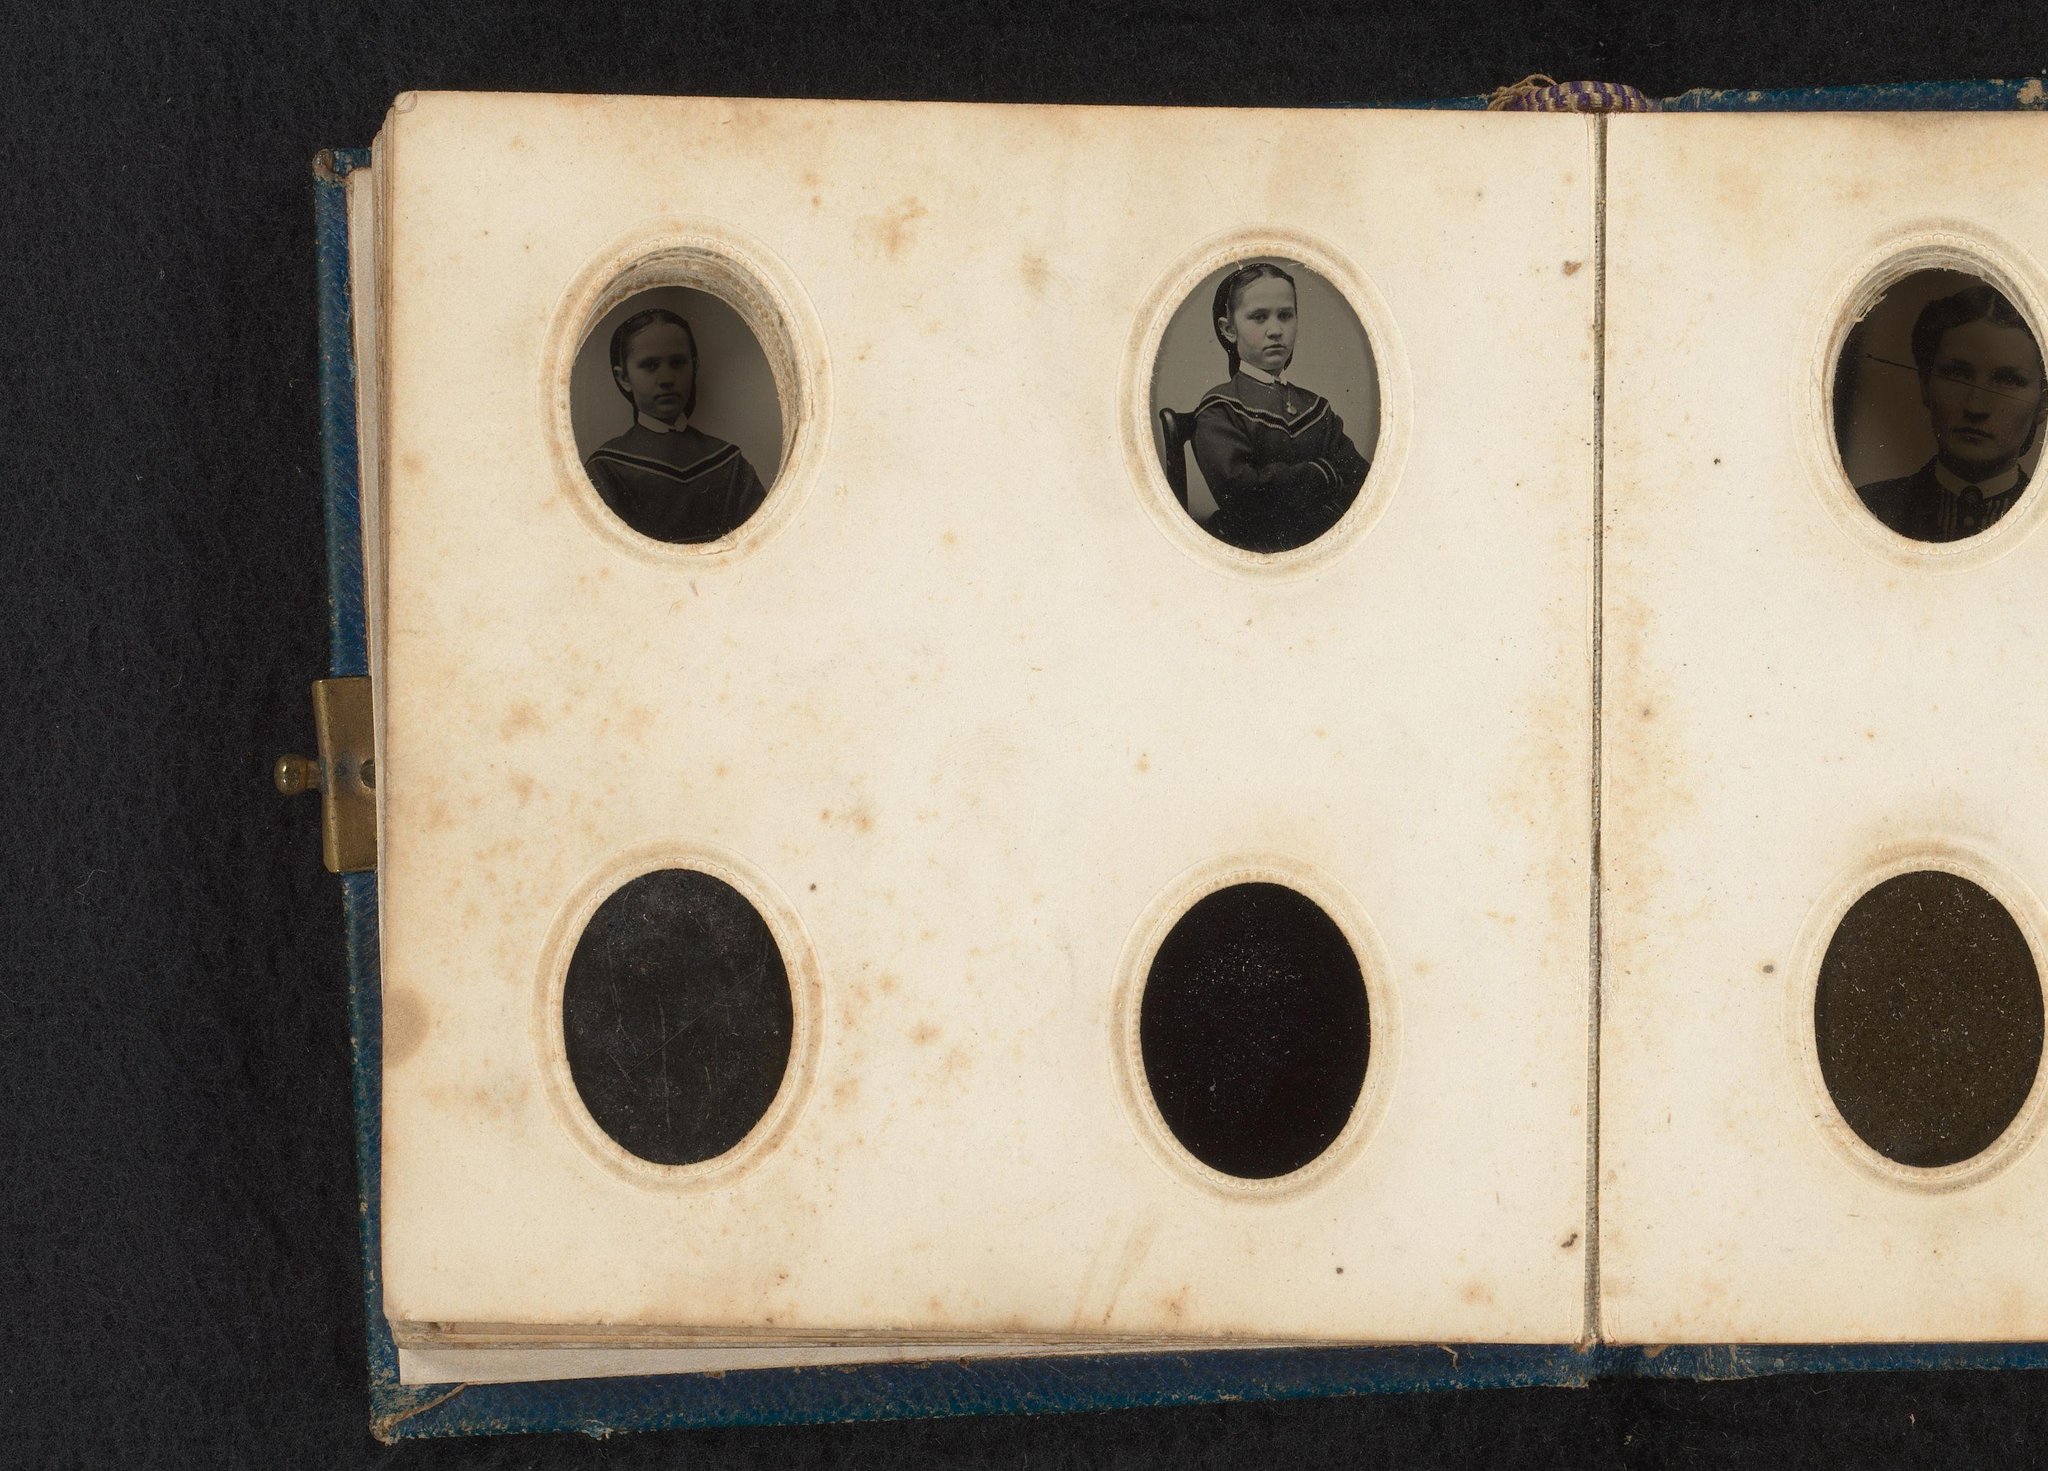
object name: album leaf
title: Portret van een meisje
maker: Anonymous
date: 1855-1900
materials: cardboard, iron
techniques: ferrotyping, hand coloring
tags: historical persons not known by name - bb - woman, girl (child between toddler and youth)